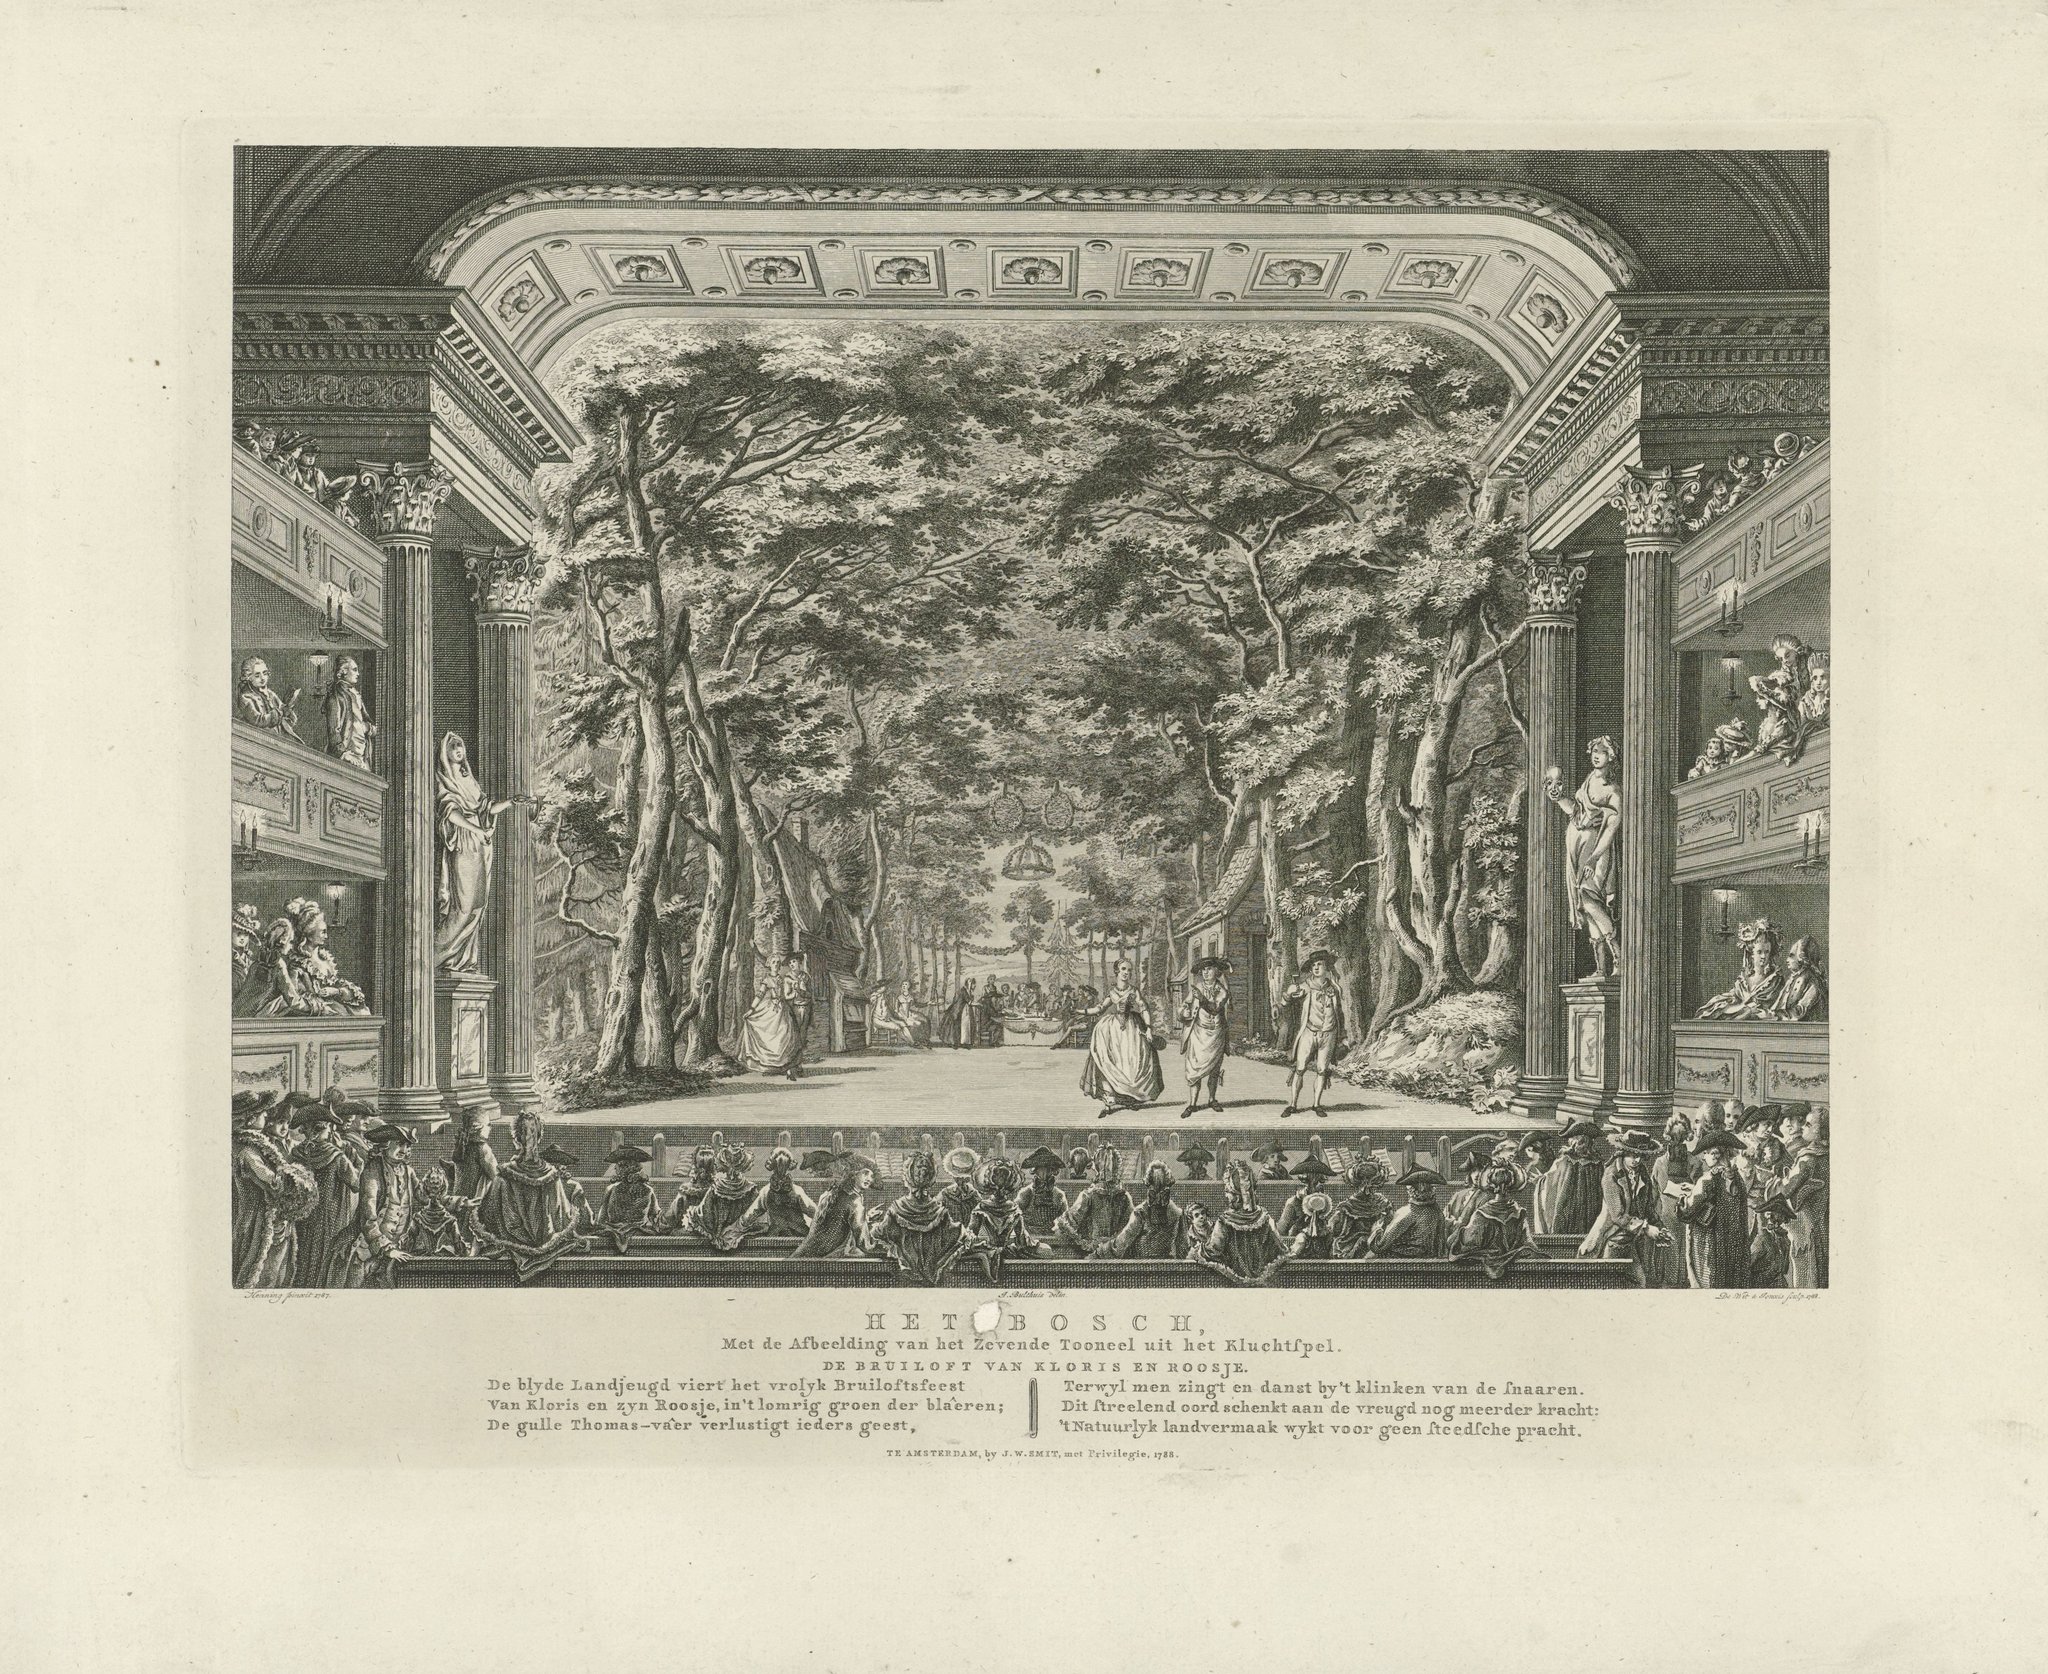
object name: print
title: Toneeldecors van de nieuwe Amsterdamse Schouwburg, 1787-1794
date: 1788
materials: paper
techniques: engraving, etching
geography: northern netherlands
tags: theatre, theatrical performance, stage design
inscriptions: collector's mark: Lugt 2228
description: Toneelvoorstelling in de nieuwe Amsterdamse Schouwburg met het coulissendecor Het Bosch, met scène uit De Bruiloft van Kloris en Roosje. Het decor gedrukt van een aparte plaat binnen een passe-partout met de zaal, zijloges, pilaren met standbeelden en de façade van het toneel. In het onderschrift een zesregelig vers. Onderdeel van de serie van veertien toneeldecors van de nieuwe Amsterdamse Schouwburg, 1787-1794.